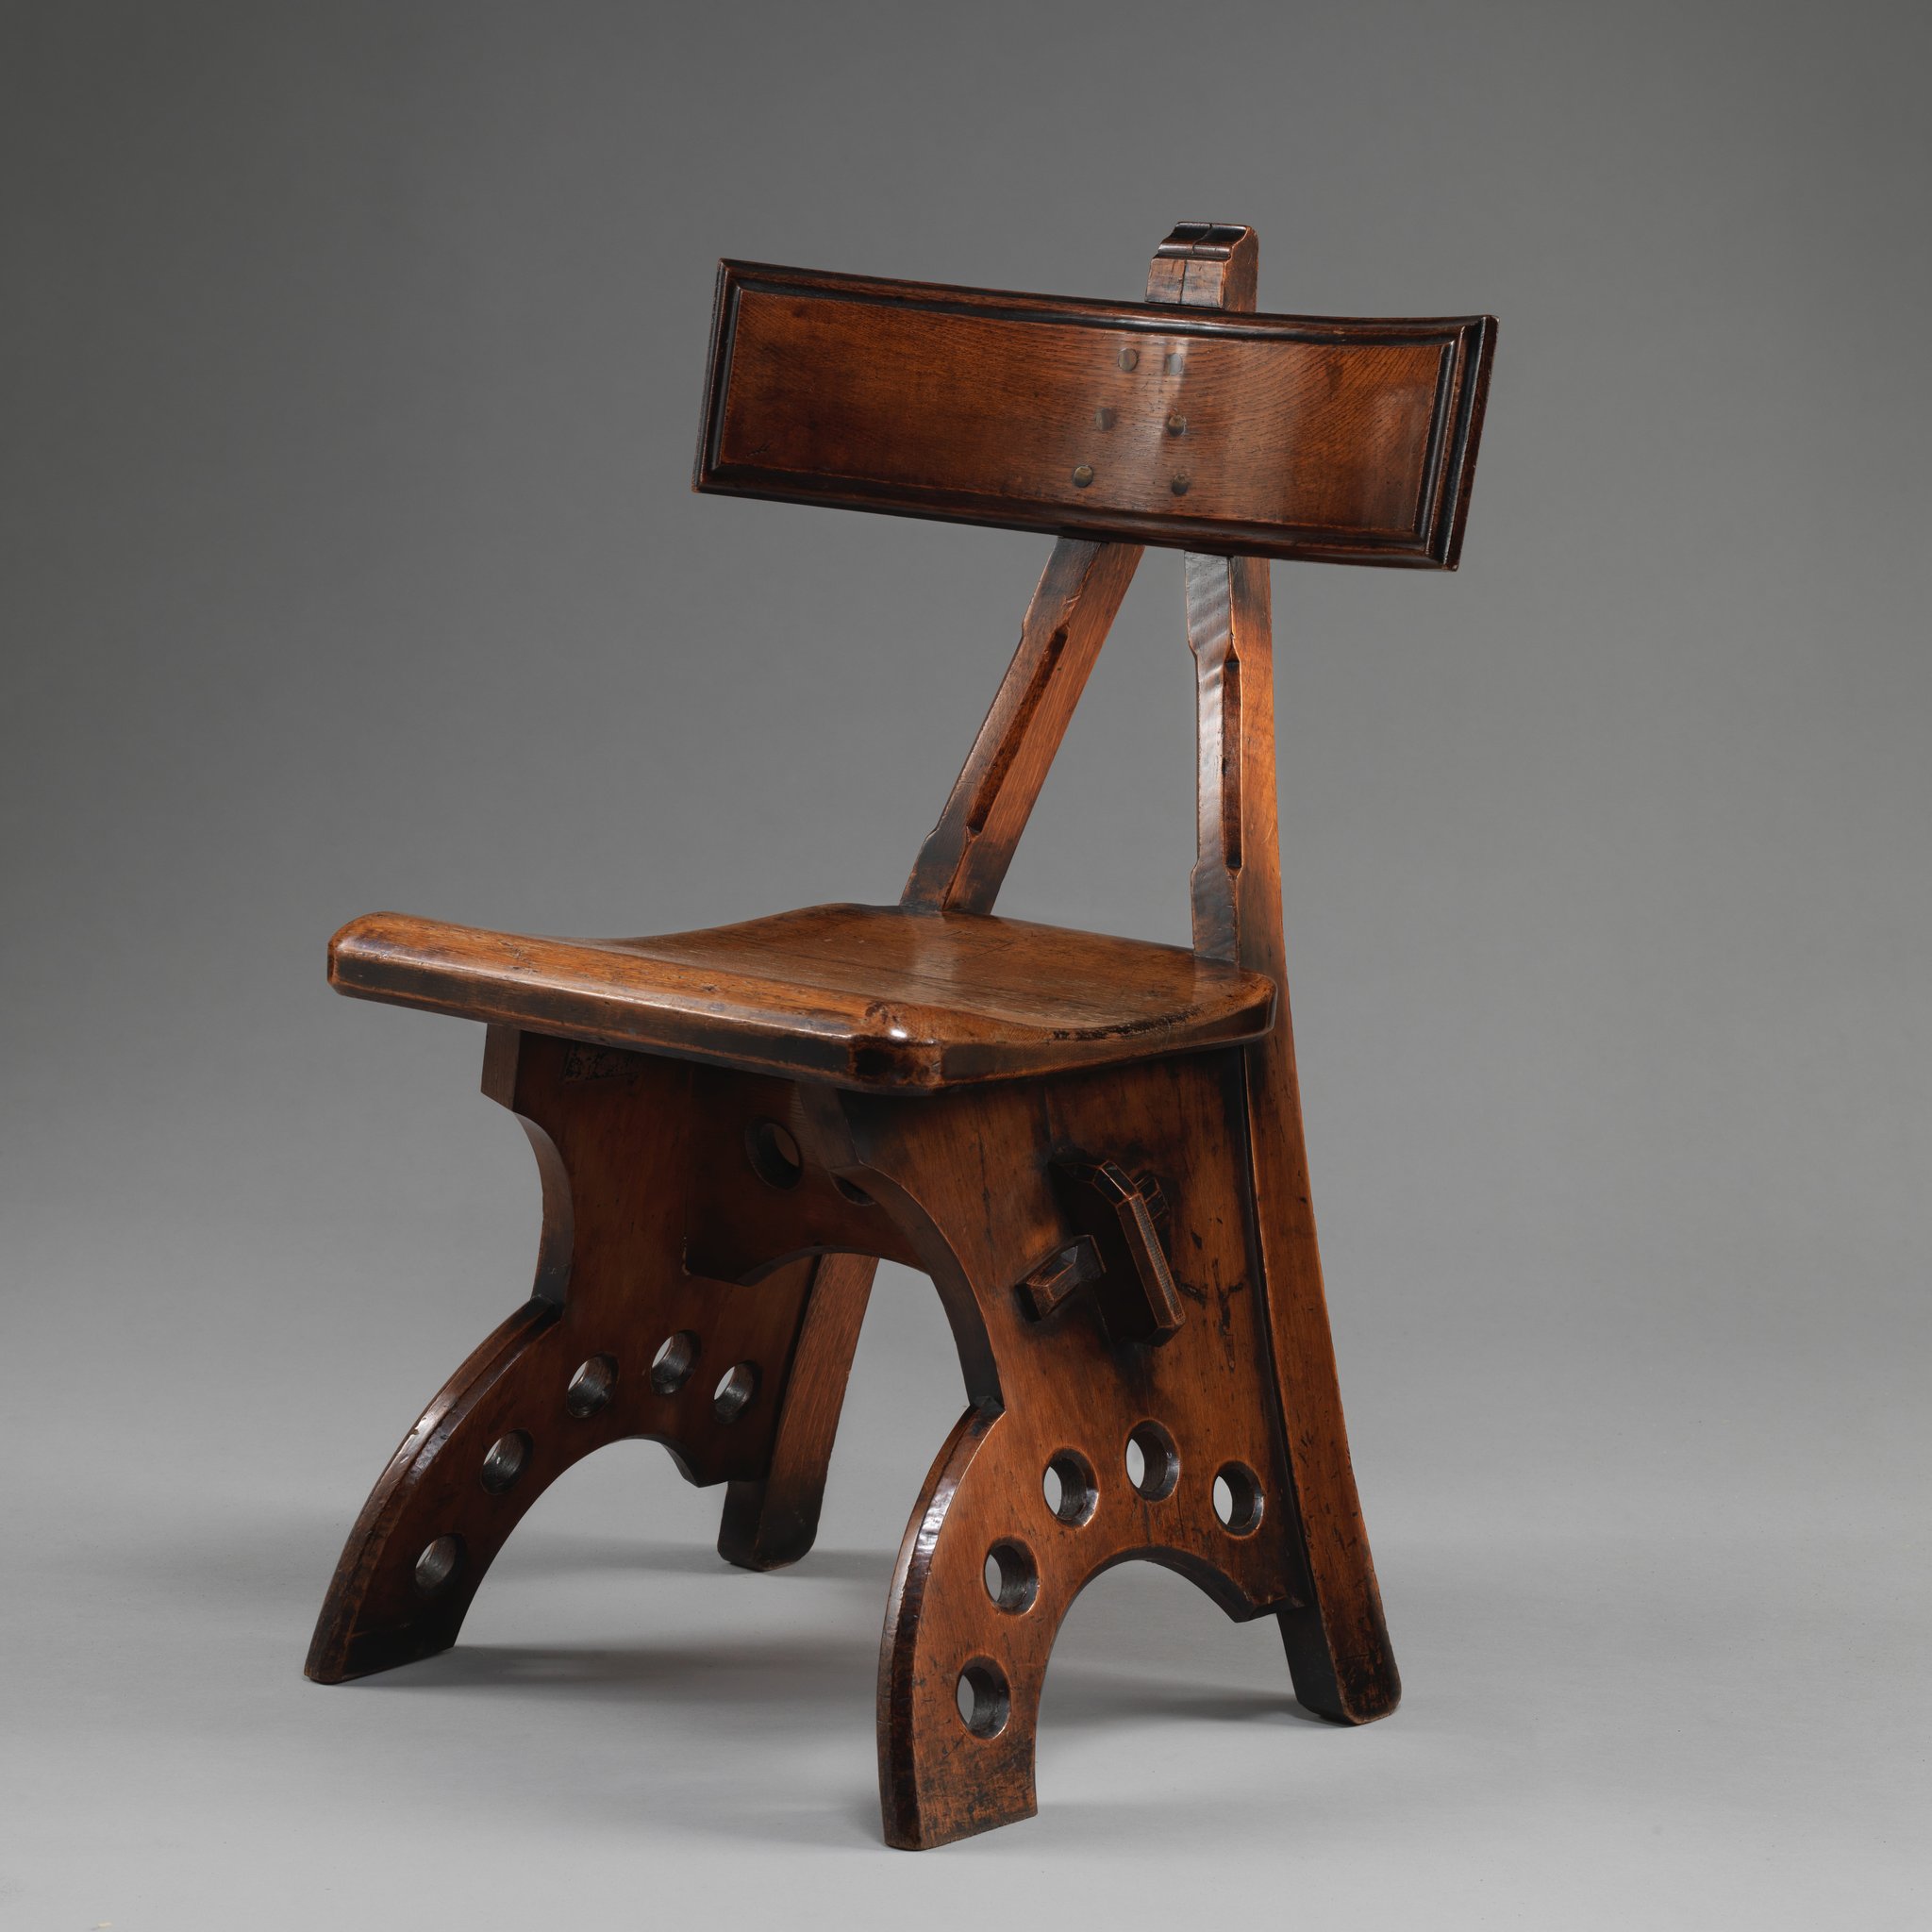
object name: side chair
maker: edward welby pugin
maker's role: designer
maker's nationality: british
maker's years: 1834-1875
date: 1870-1880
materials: horn, wood